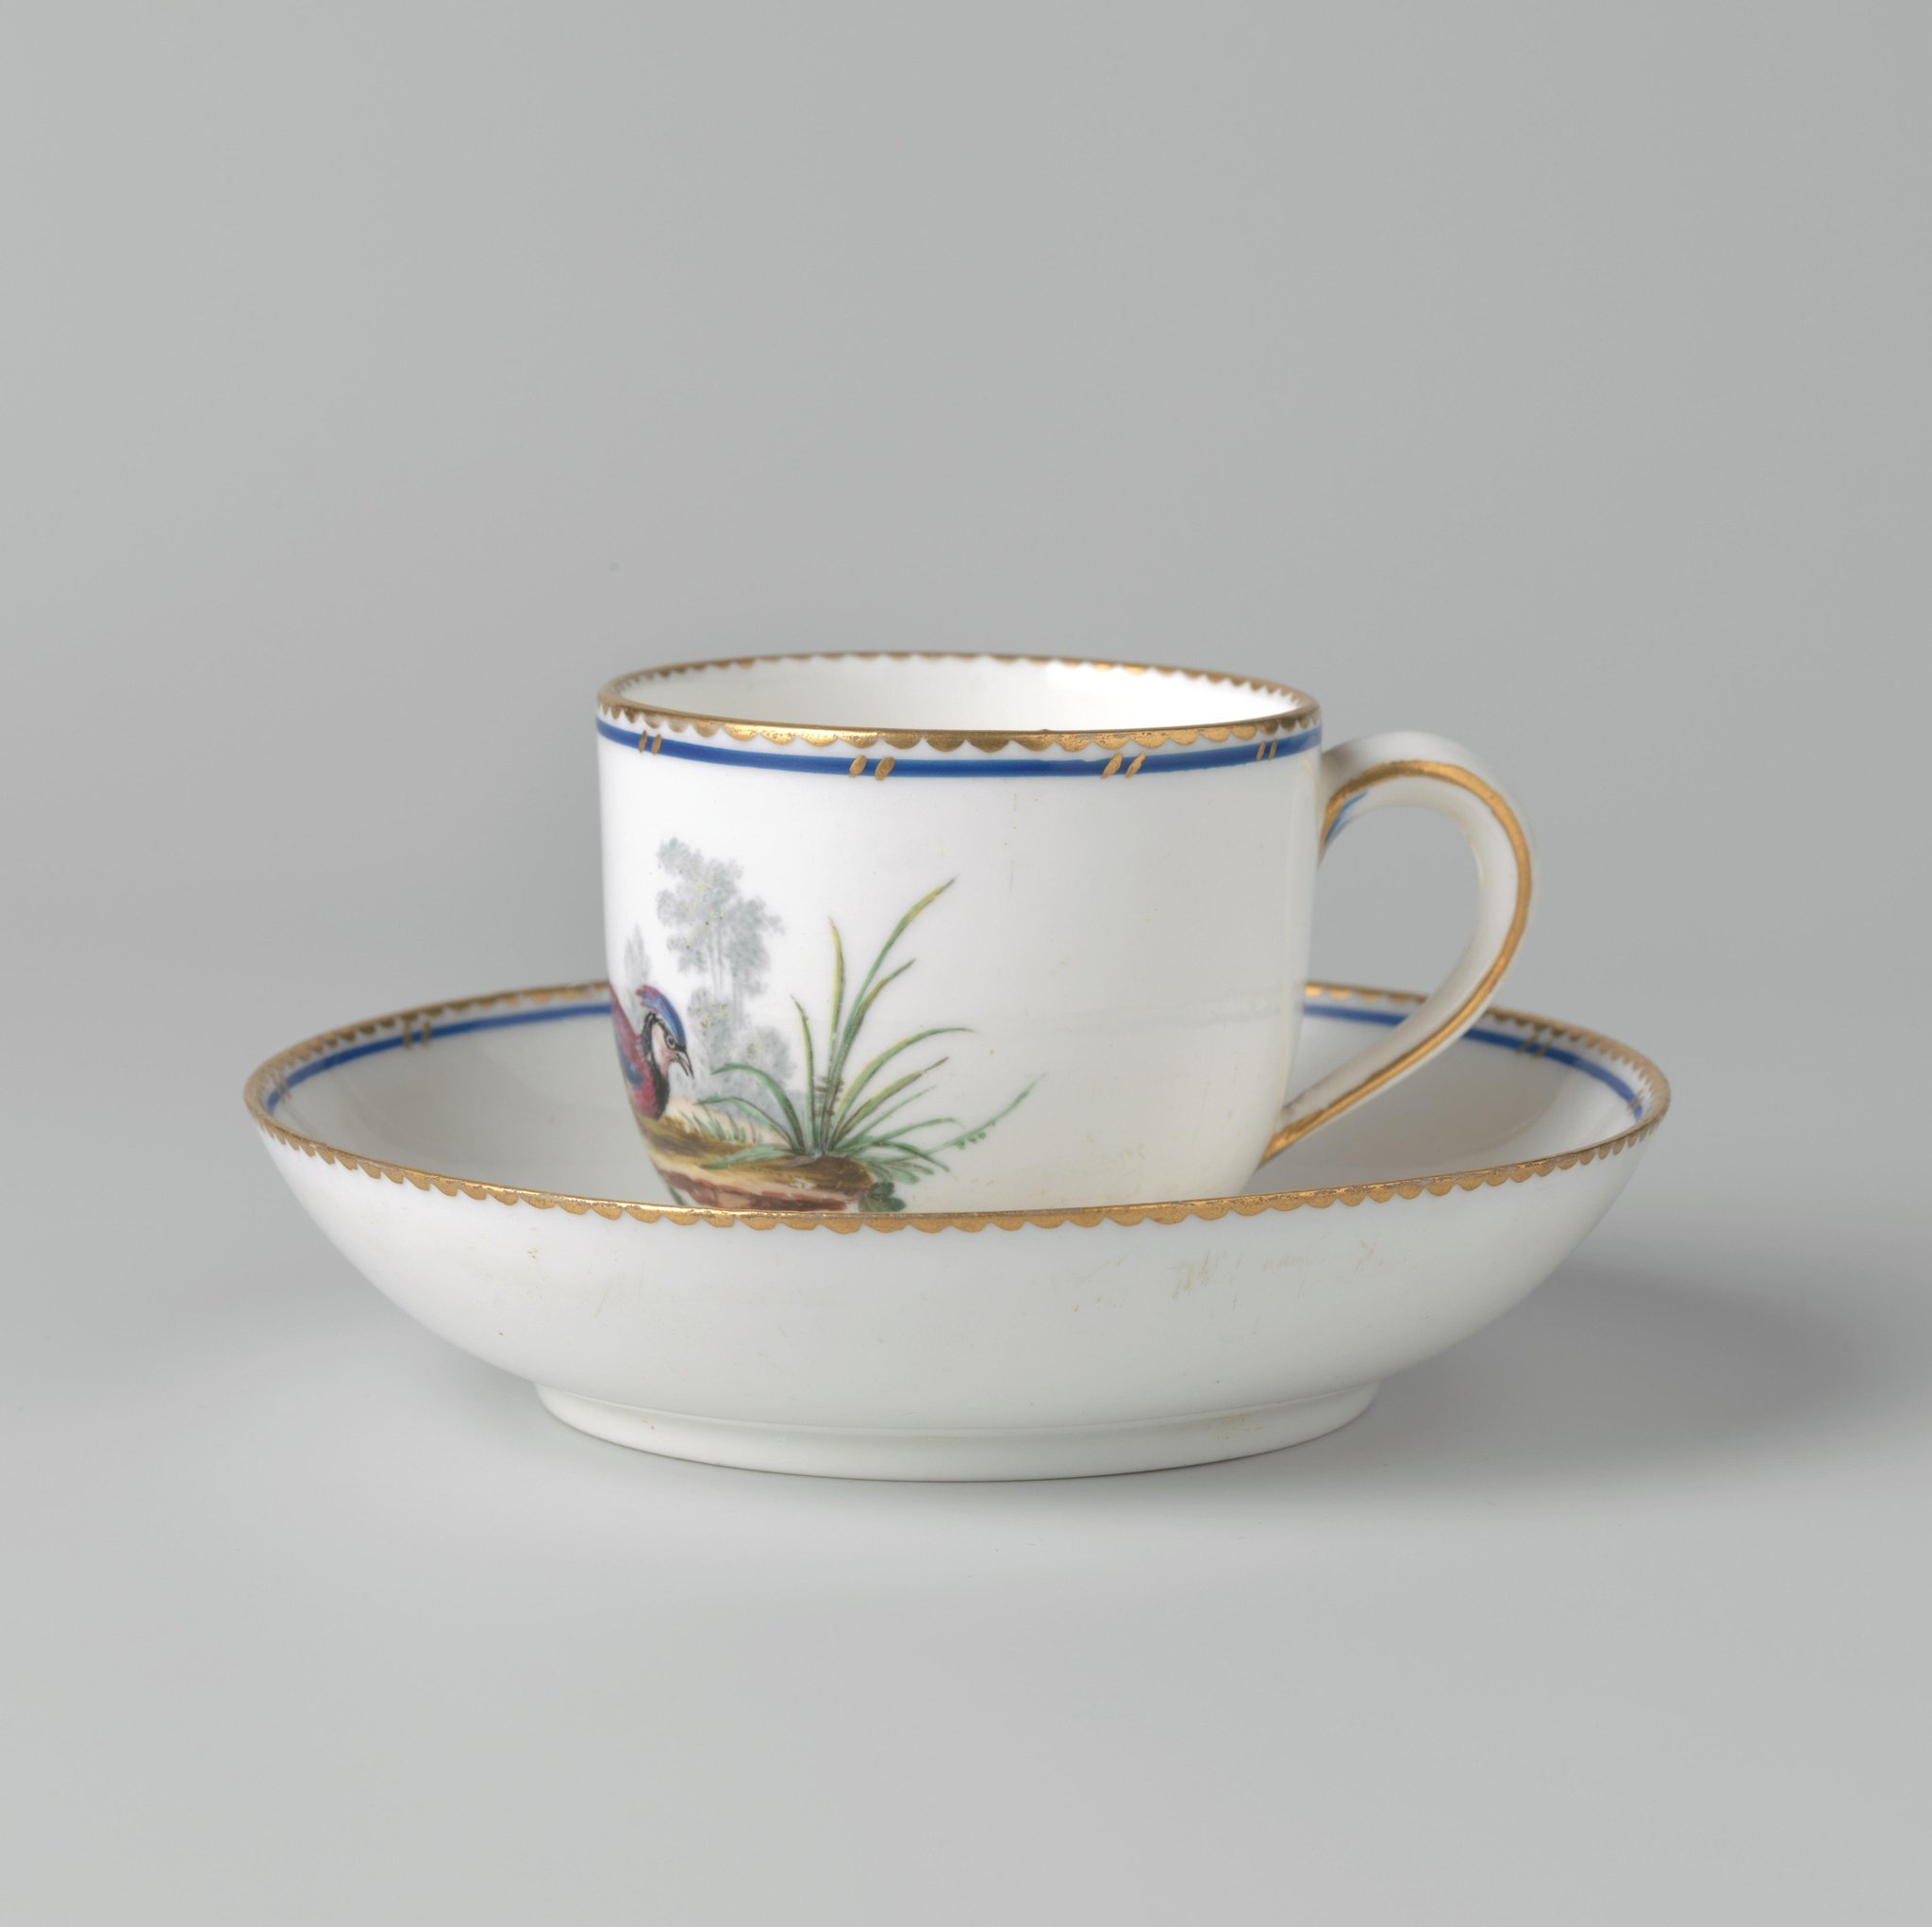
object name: cup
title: Cup with a bird in a landscape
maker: Anonymous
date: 1750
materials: glaze, gold, paint, porcelain, soft paste porcelain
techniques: firing, forming, gilding, turning, vitrification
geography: vincennes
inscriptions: mark: ‘dubbele L met daarin een S/ X (in vierkant)/ ag’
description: Kop van soft-paste porselein (pâte tendre) met C-vormig oor, beschilderd op het glazuur in emailkleuren en goud. Op de buitenwand een vogel in een landschap met bomen en planten. Op de voet en de buitenrand een blauwe lijn met telkens twee schuine, gouden strepen. Op de rand, aan de binnen- en buitenzijde een band van halve gouden bollen. Gemerkt op de onderzijde met de dubbele L met daarin een S, X en X in een vierkant en ag.